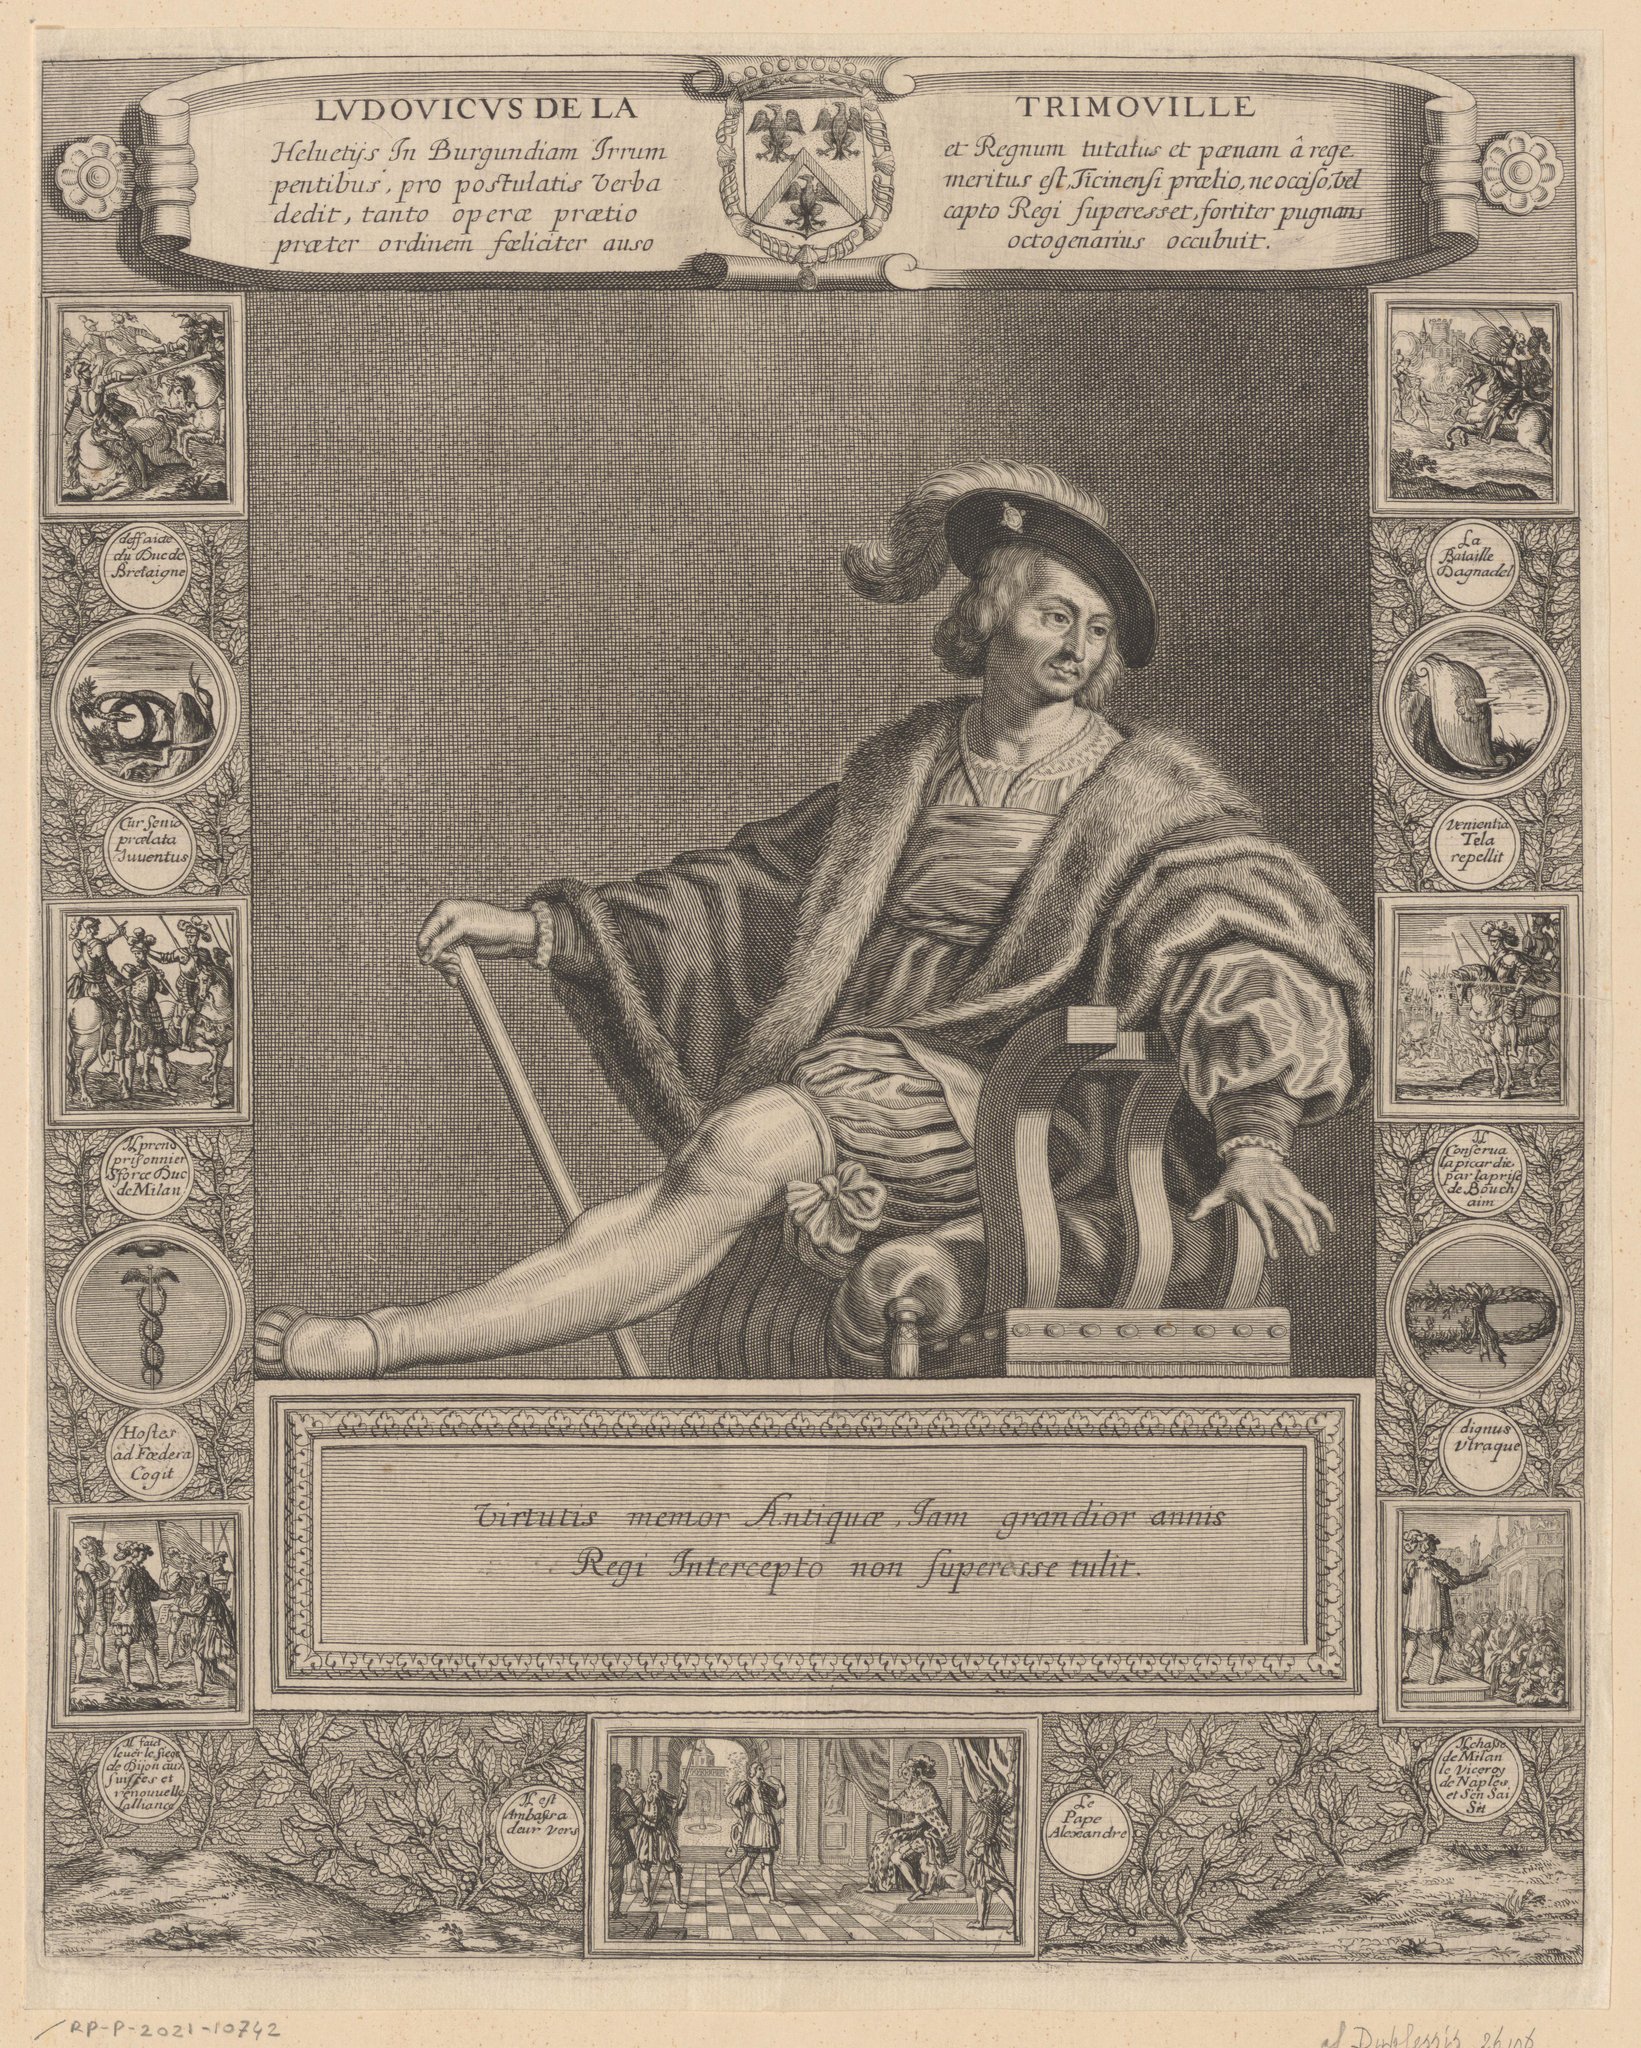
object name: print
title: Portretten uit het paleis van kardinaal de Richelieu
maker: françois bignon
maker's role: print maker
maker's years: 1620-1671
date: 1650-1690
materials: paper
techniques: engraving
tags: snakes, historical persons, battle, trees: olive-tree, aesculapian sign, sitting on an elevation, armorial bearing, heraldry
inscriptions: collector's mark: Lugt 2228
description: Prent mogelijk uit: Vulson de La Colombière, Marc de. Les portraits des hommes illustres François qui sont peints dans la gallerie du Palais cardinal de Richelieu (...). Parijs: Henry Sara et al., 1650. Of uit latere publicaties (1655, 1662, 1690 en 1690).